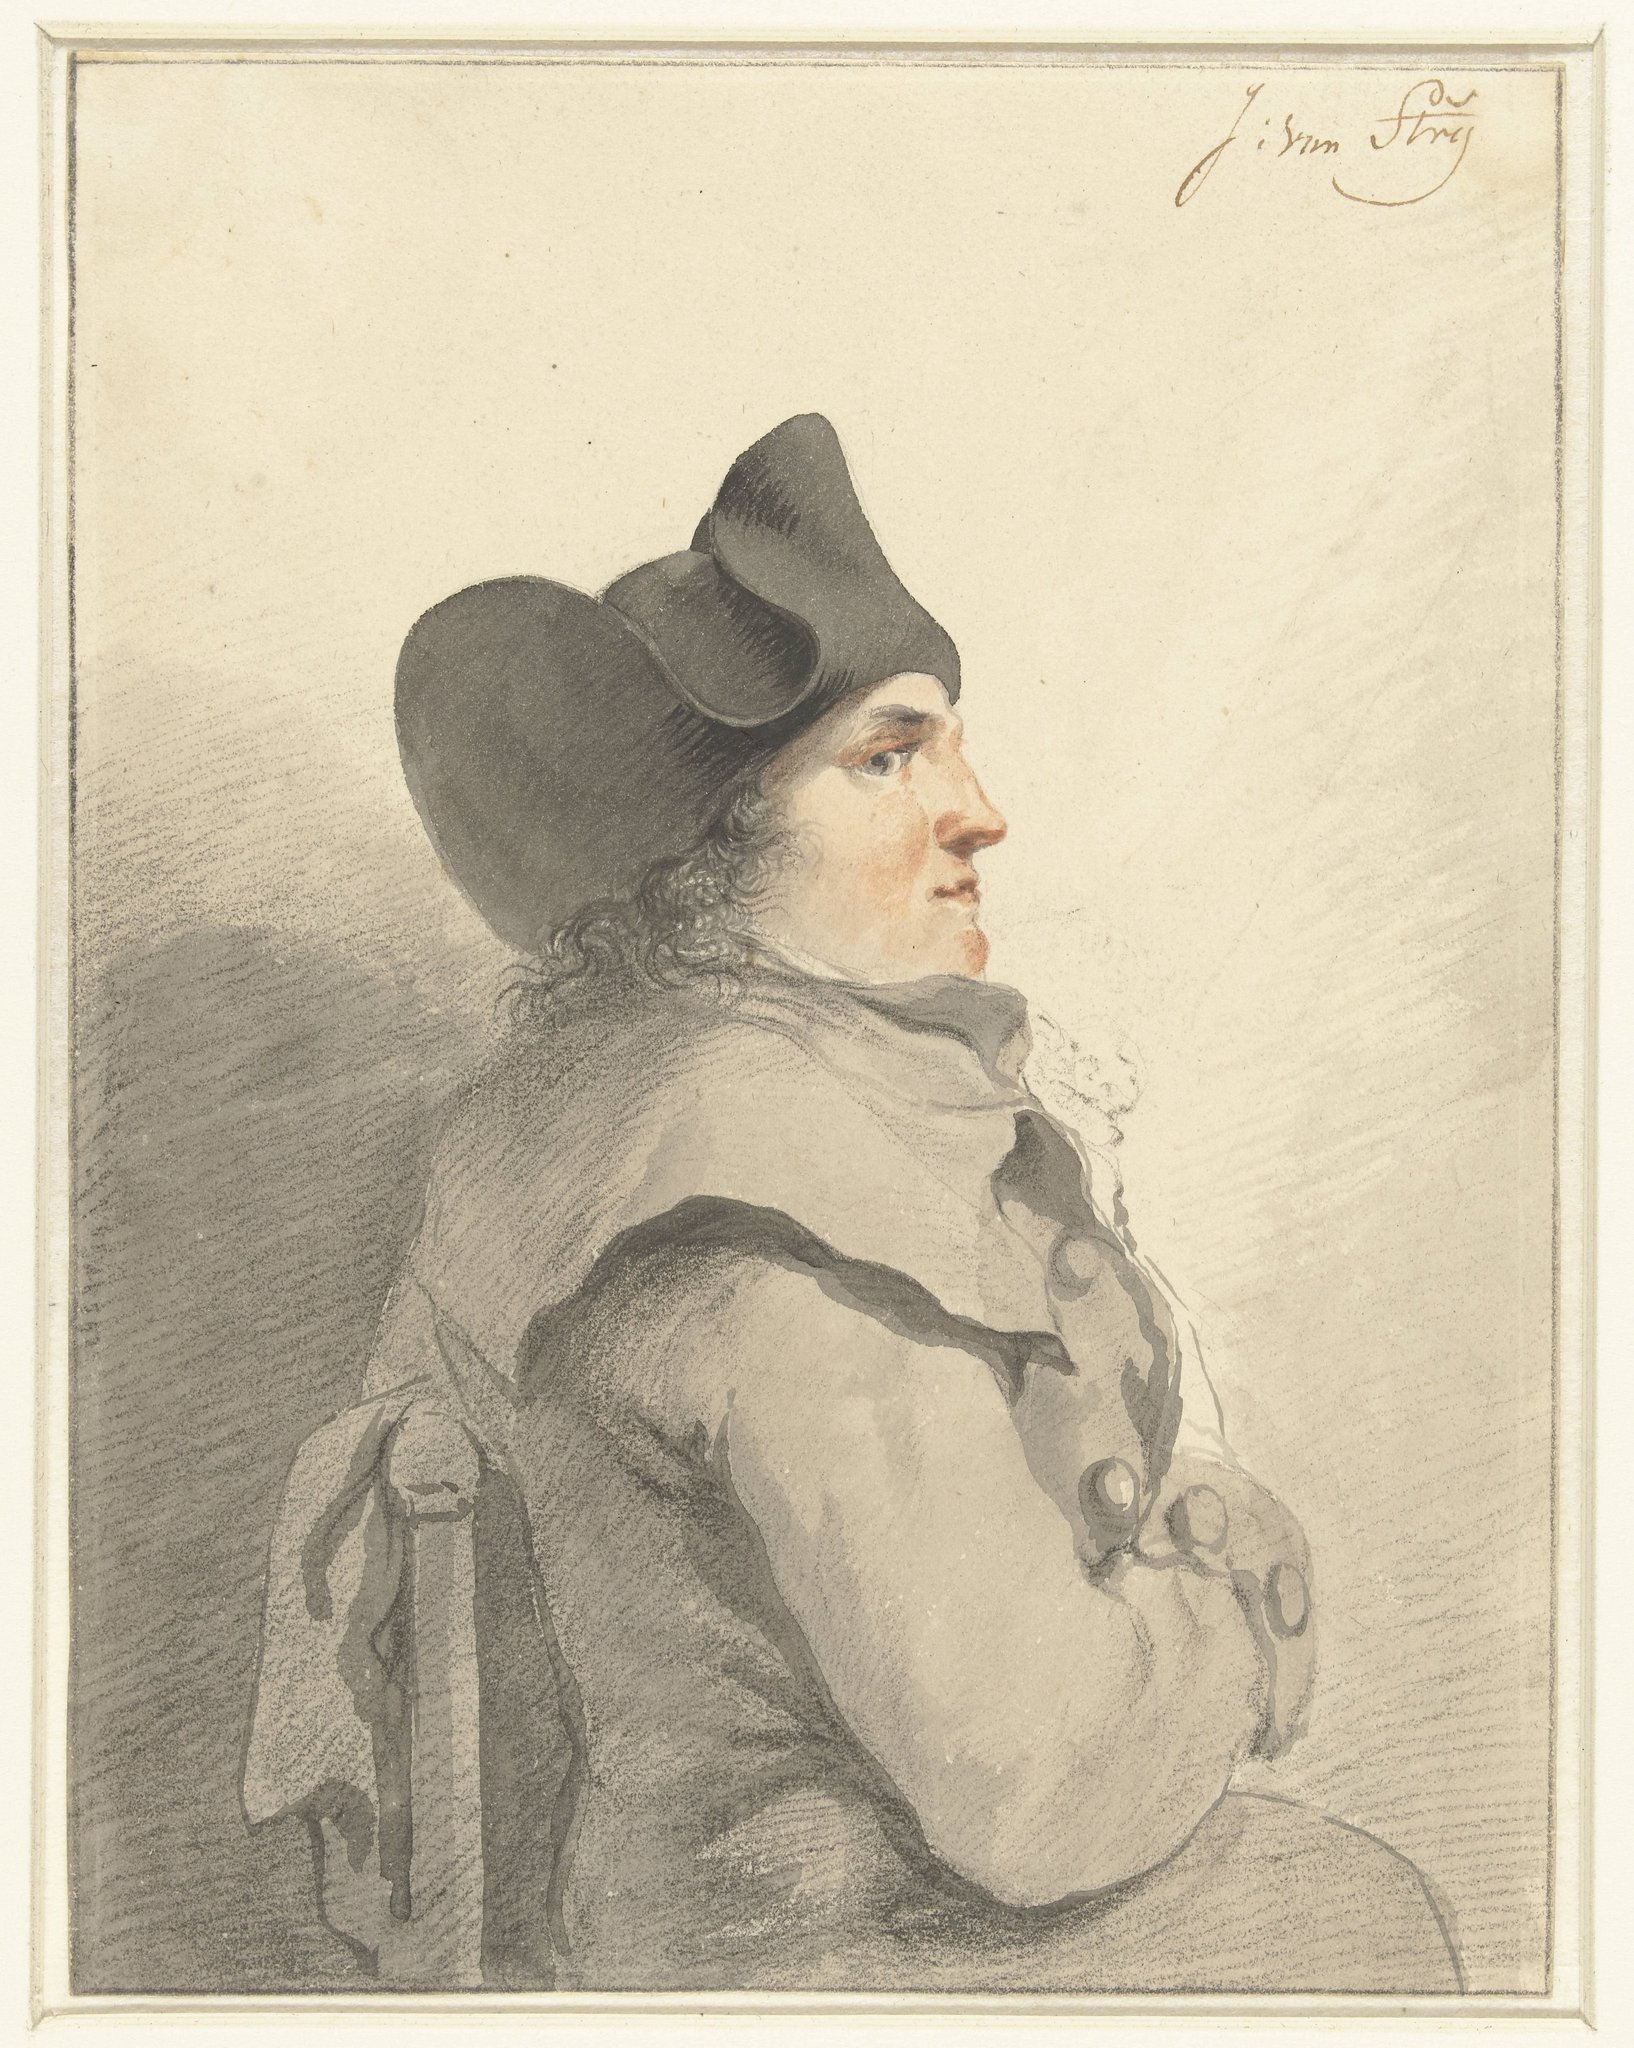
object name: drawing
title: Zittende man met zwarte steek, in profiel, naar rechts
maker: jacob van strij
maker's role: draughtsman, painter, print maker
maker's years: 1756-1815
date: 1766-1815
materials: chalk, paper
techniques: brush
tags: sitting figure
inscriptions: signature: ‘J: van Strij’